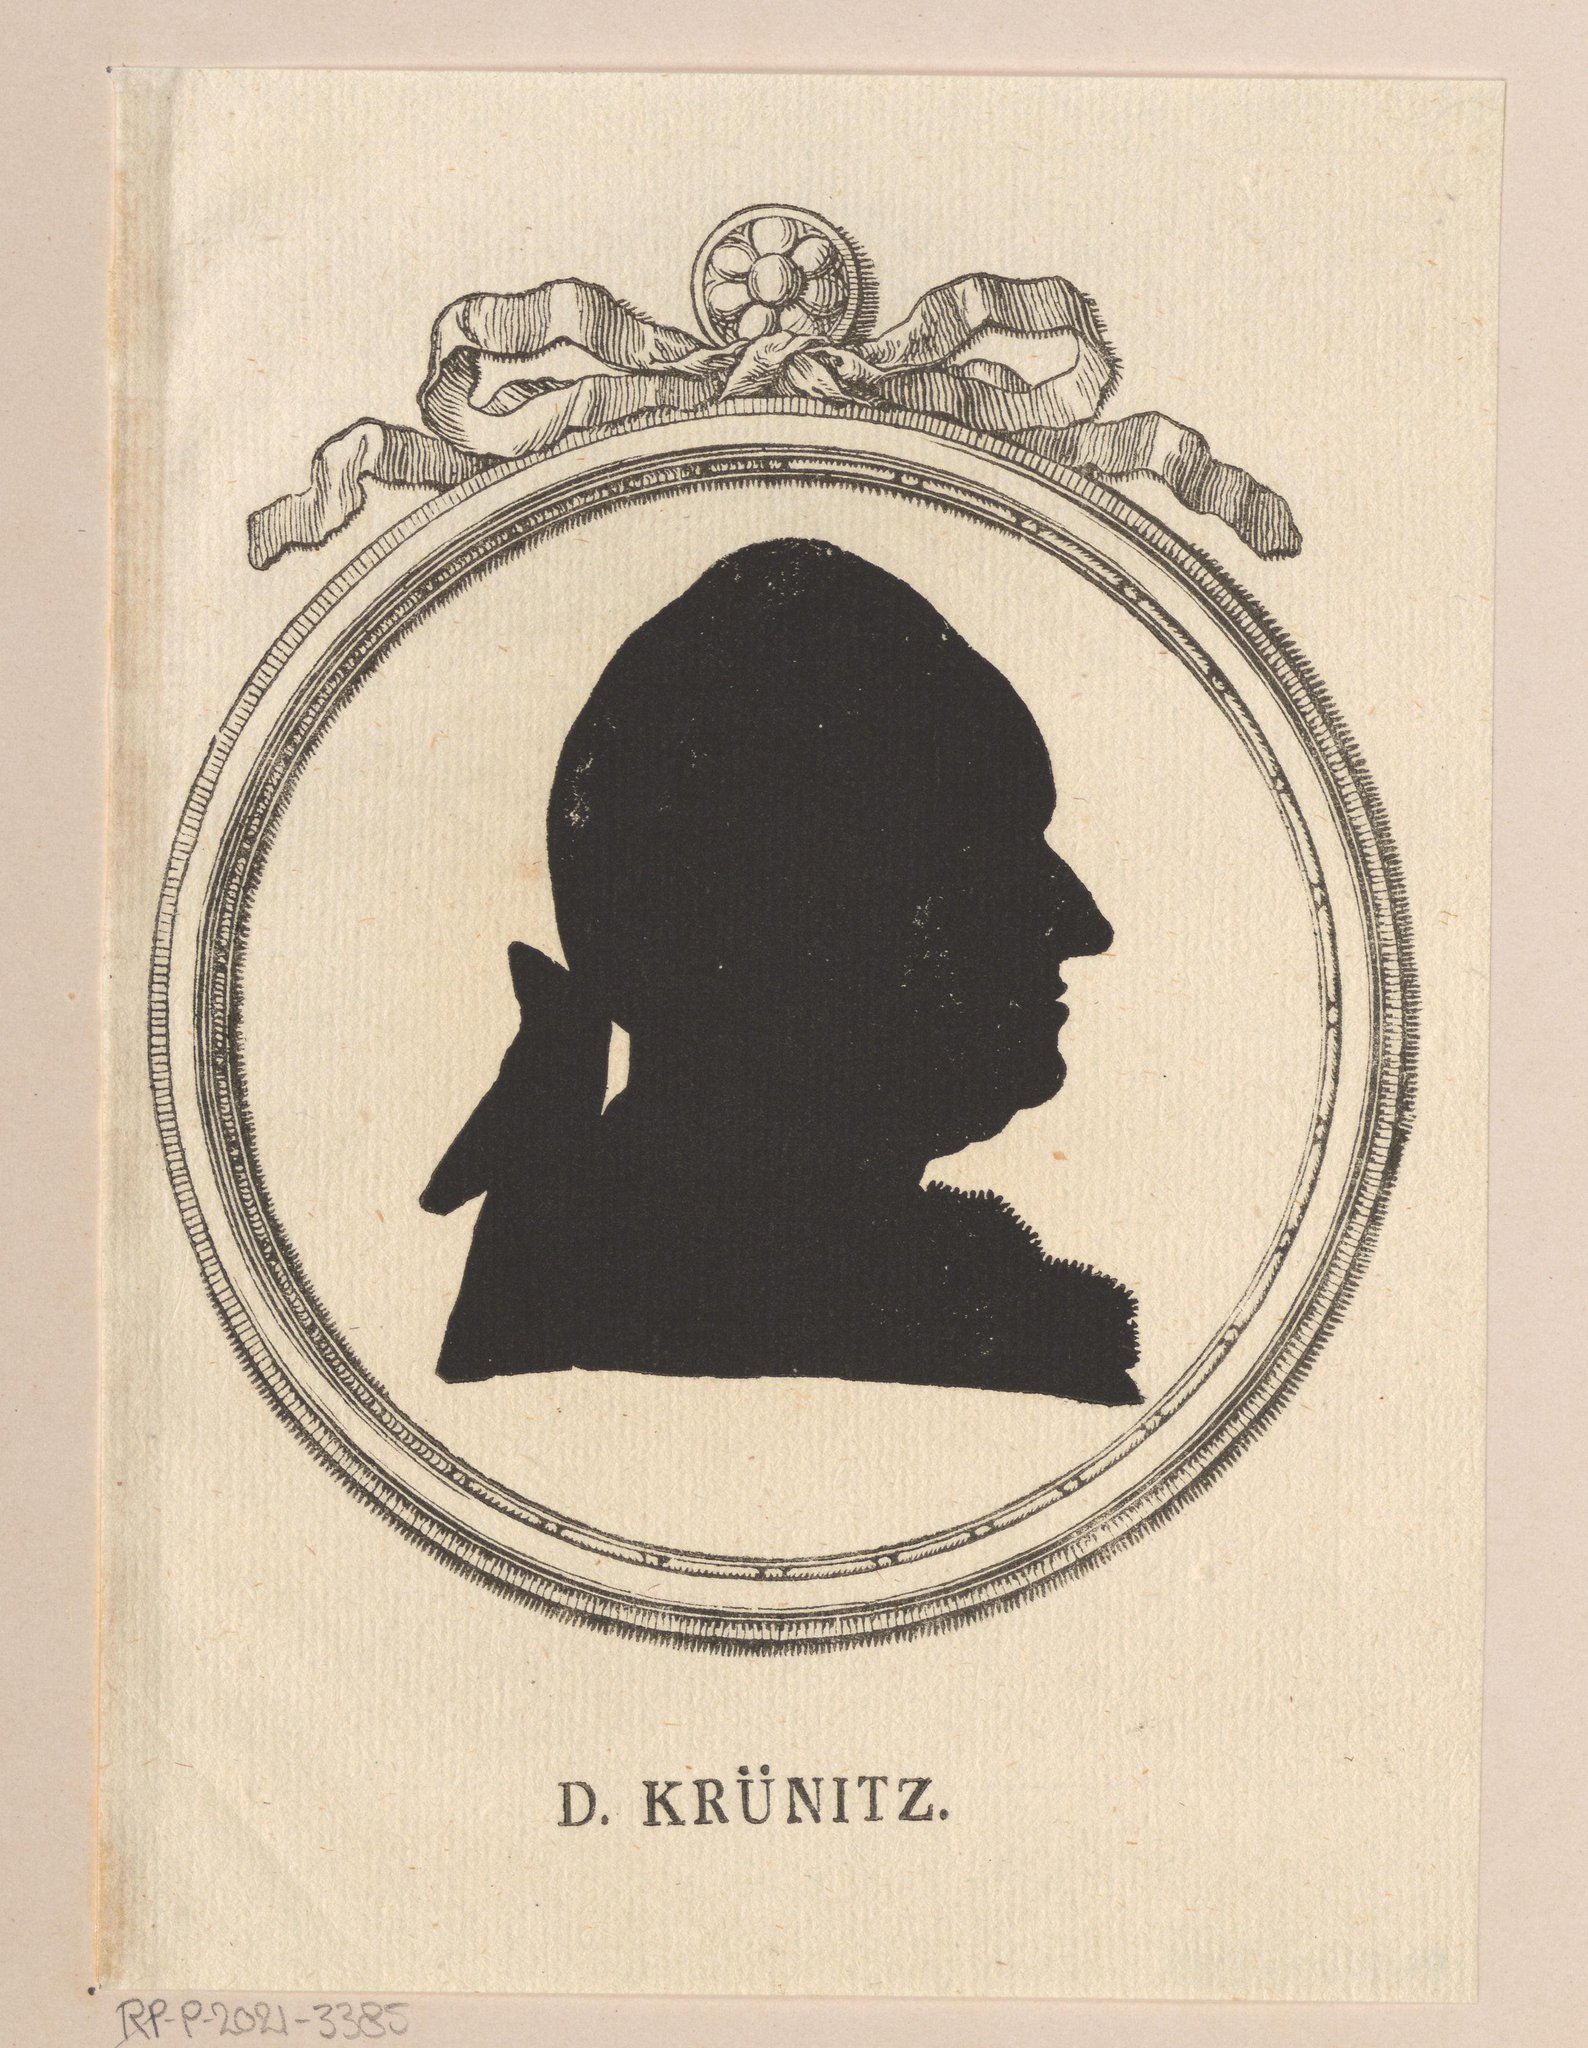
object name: print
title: Silhouetportret van Johann Georg Krünitz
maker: johann friedrich gottlieb unger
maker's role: print maker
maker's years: 1753-1804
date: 1763-1804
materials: ink, paper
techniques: brush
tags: berlin, johann georg krünitz, historical persons